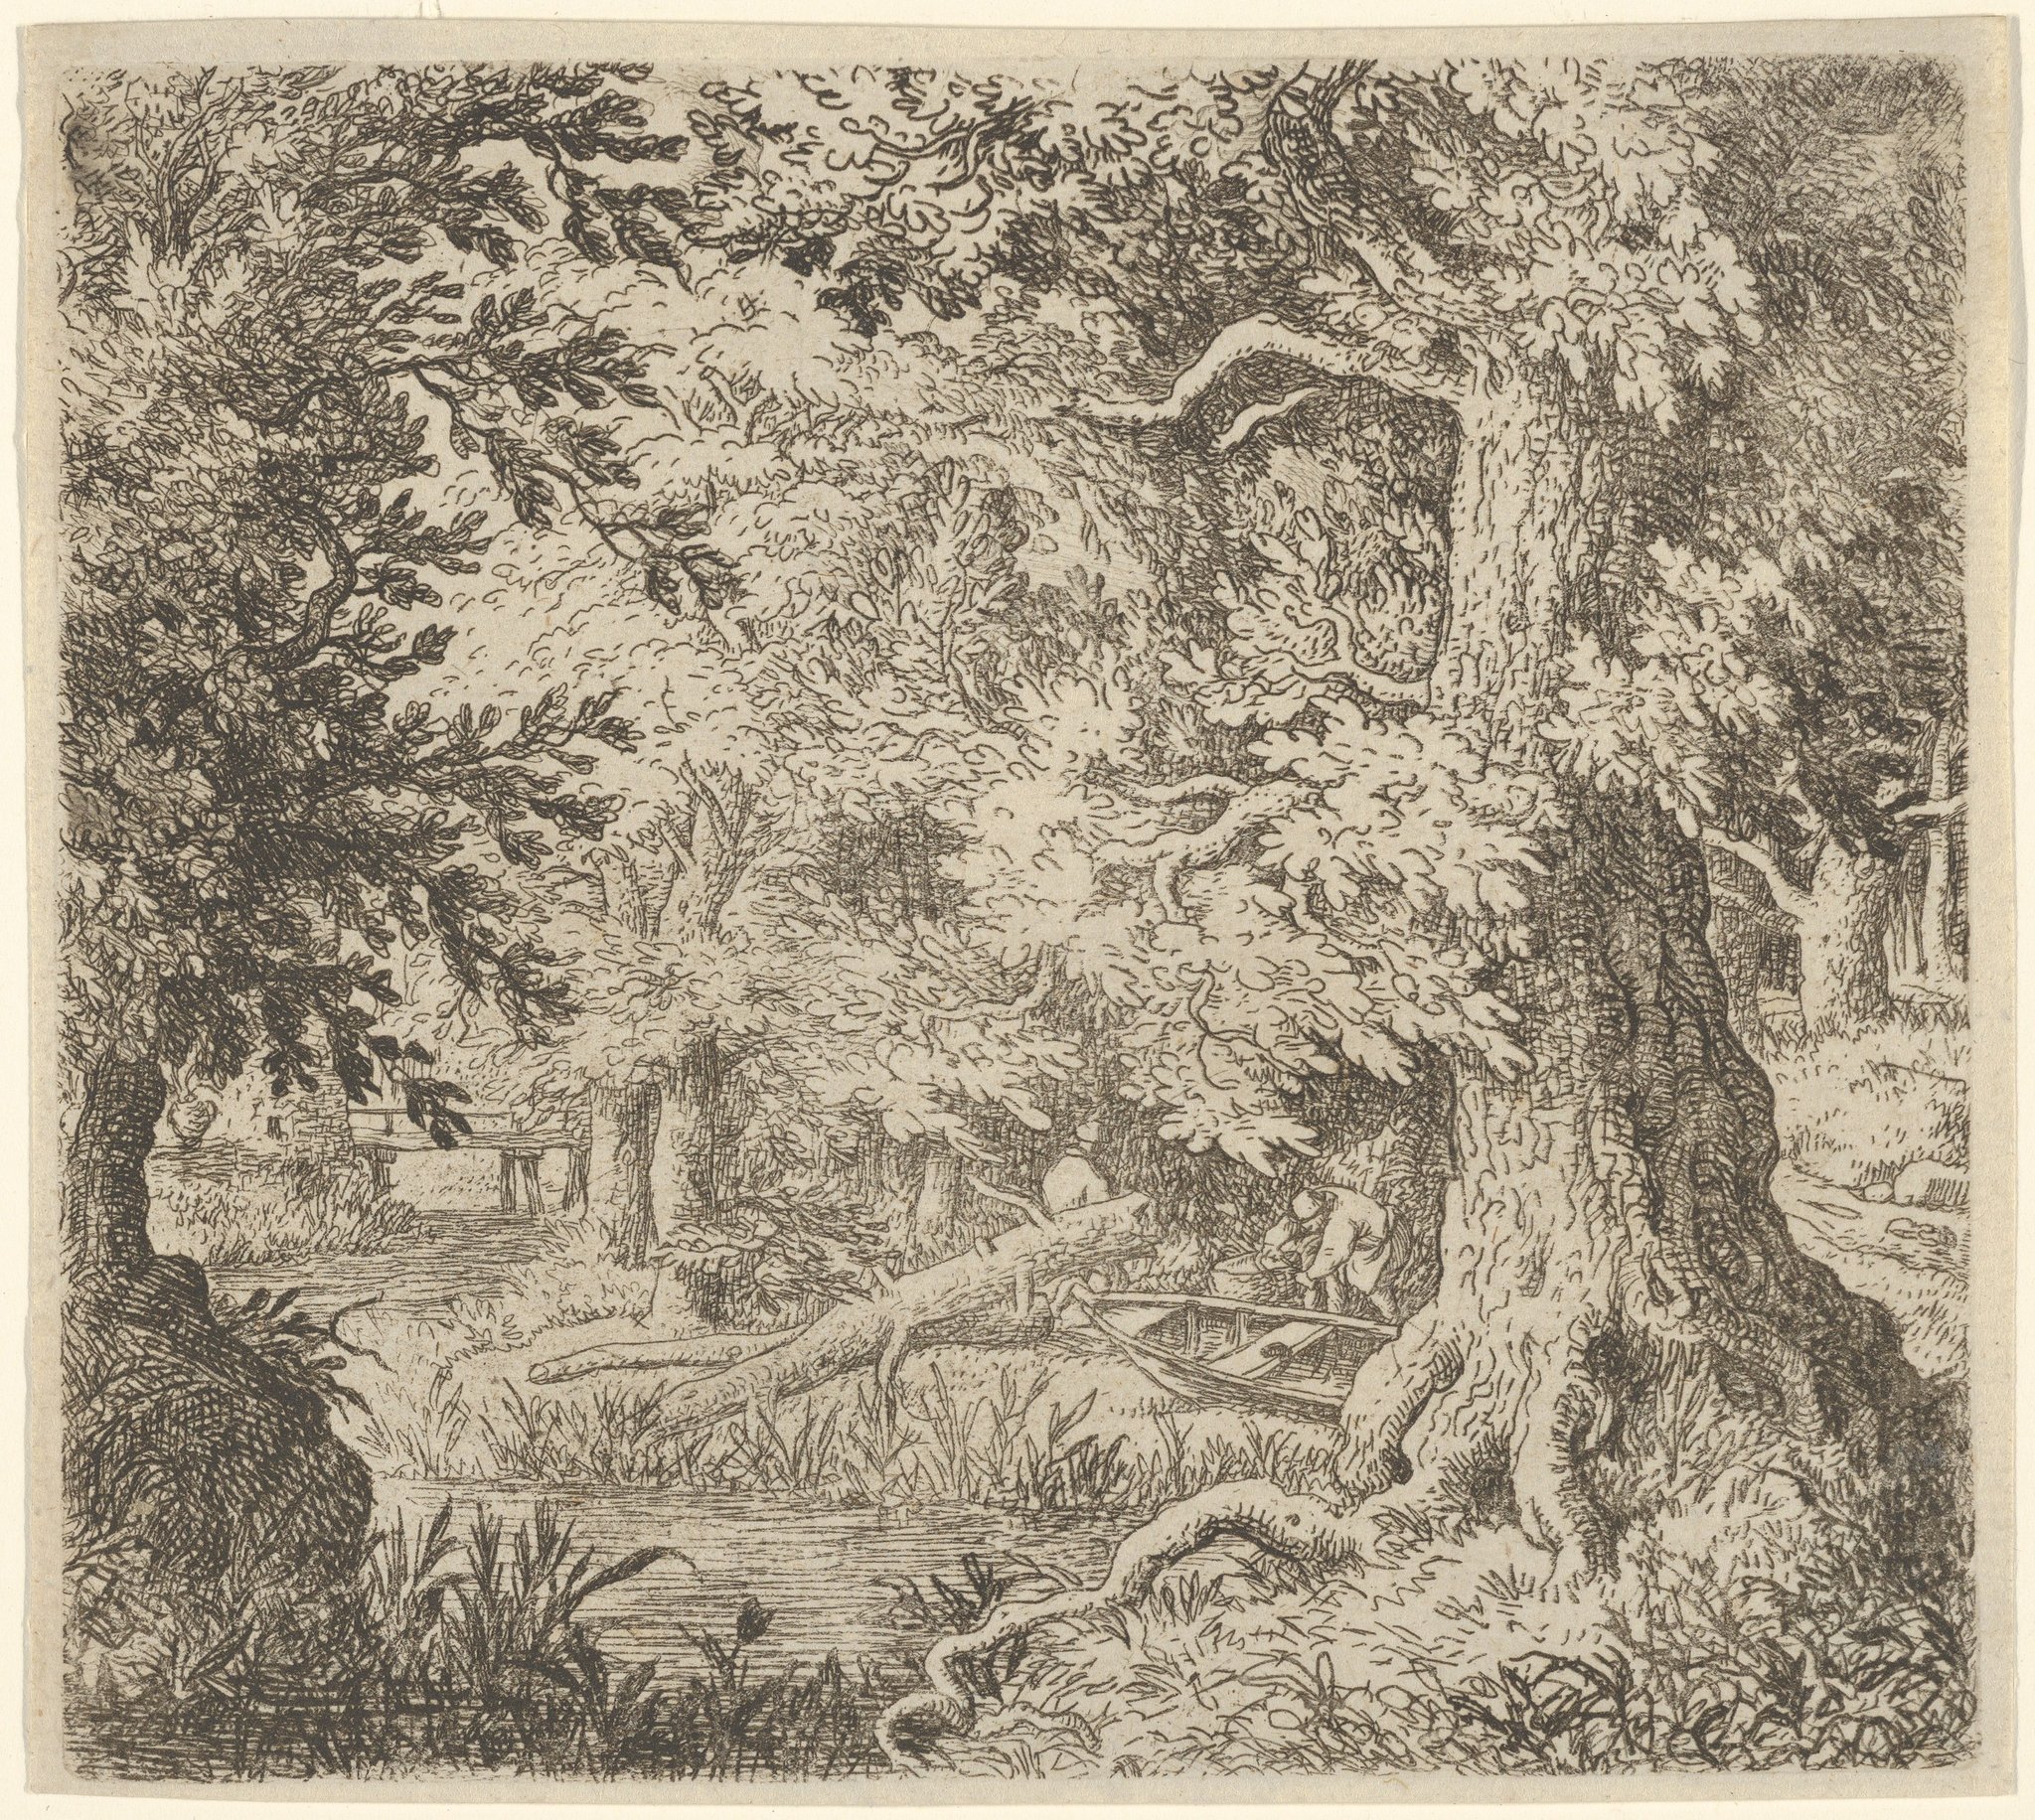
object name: print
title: The Brook in the Wood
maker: allart van everdingen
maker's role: artist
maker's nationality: dutch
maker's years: 1621-1675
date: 1621-1675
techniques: engraving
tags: human figures,bridges,trees,boats